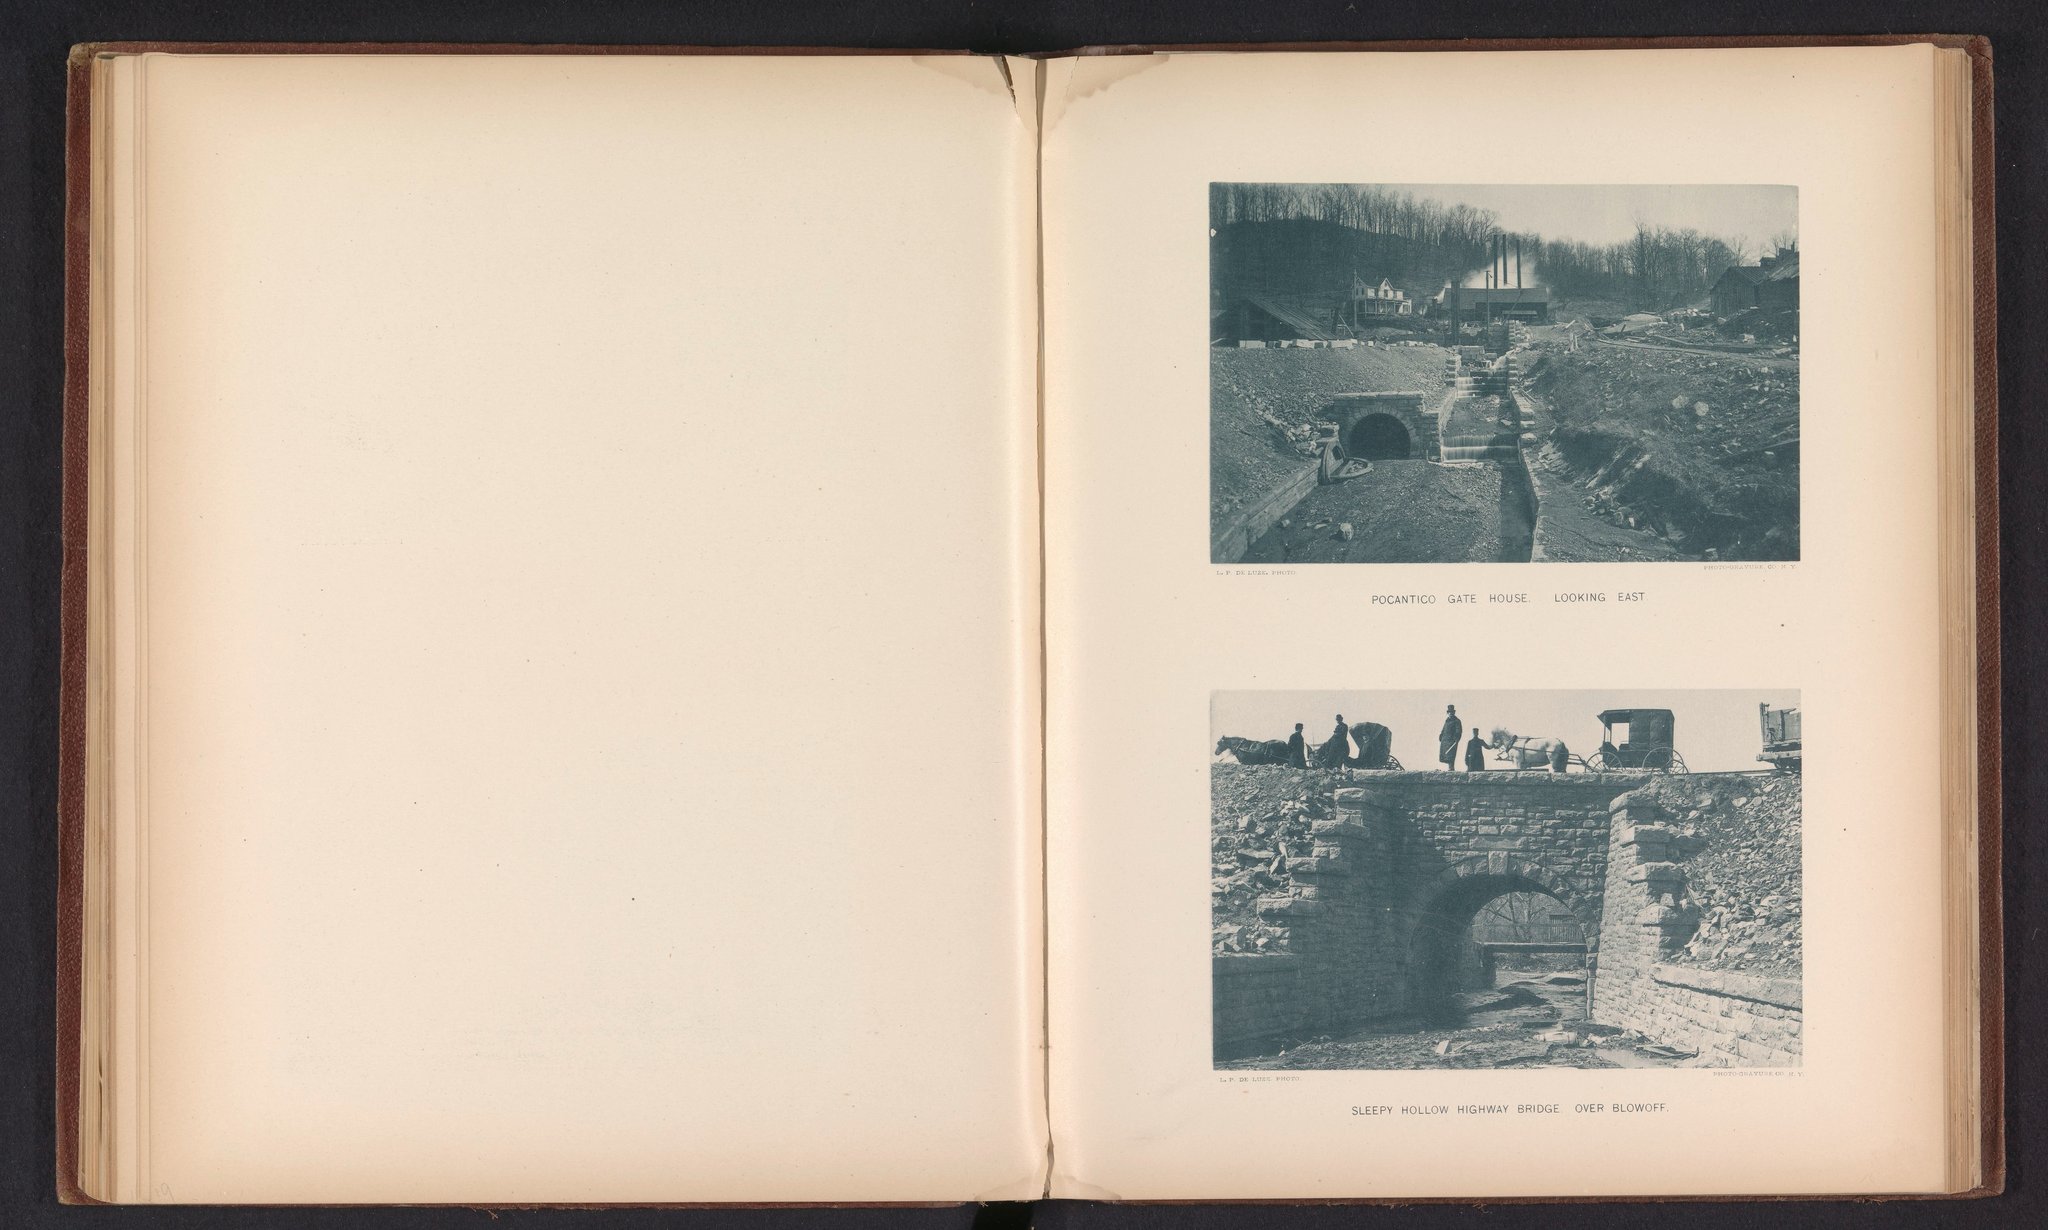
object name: page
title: Pocantico gate house. Looking east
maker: p. de luze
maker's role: fotograaf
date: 1883-1887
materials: paper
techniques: photograph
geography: new york city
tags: gate, entrance, bridge